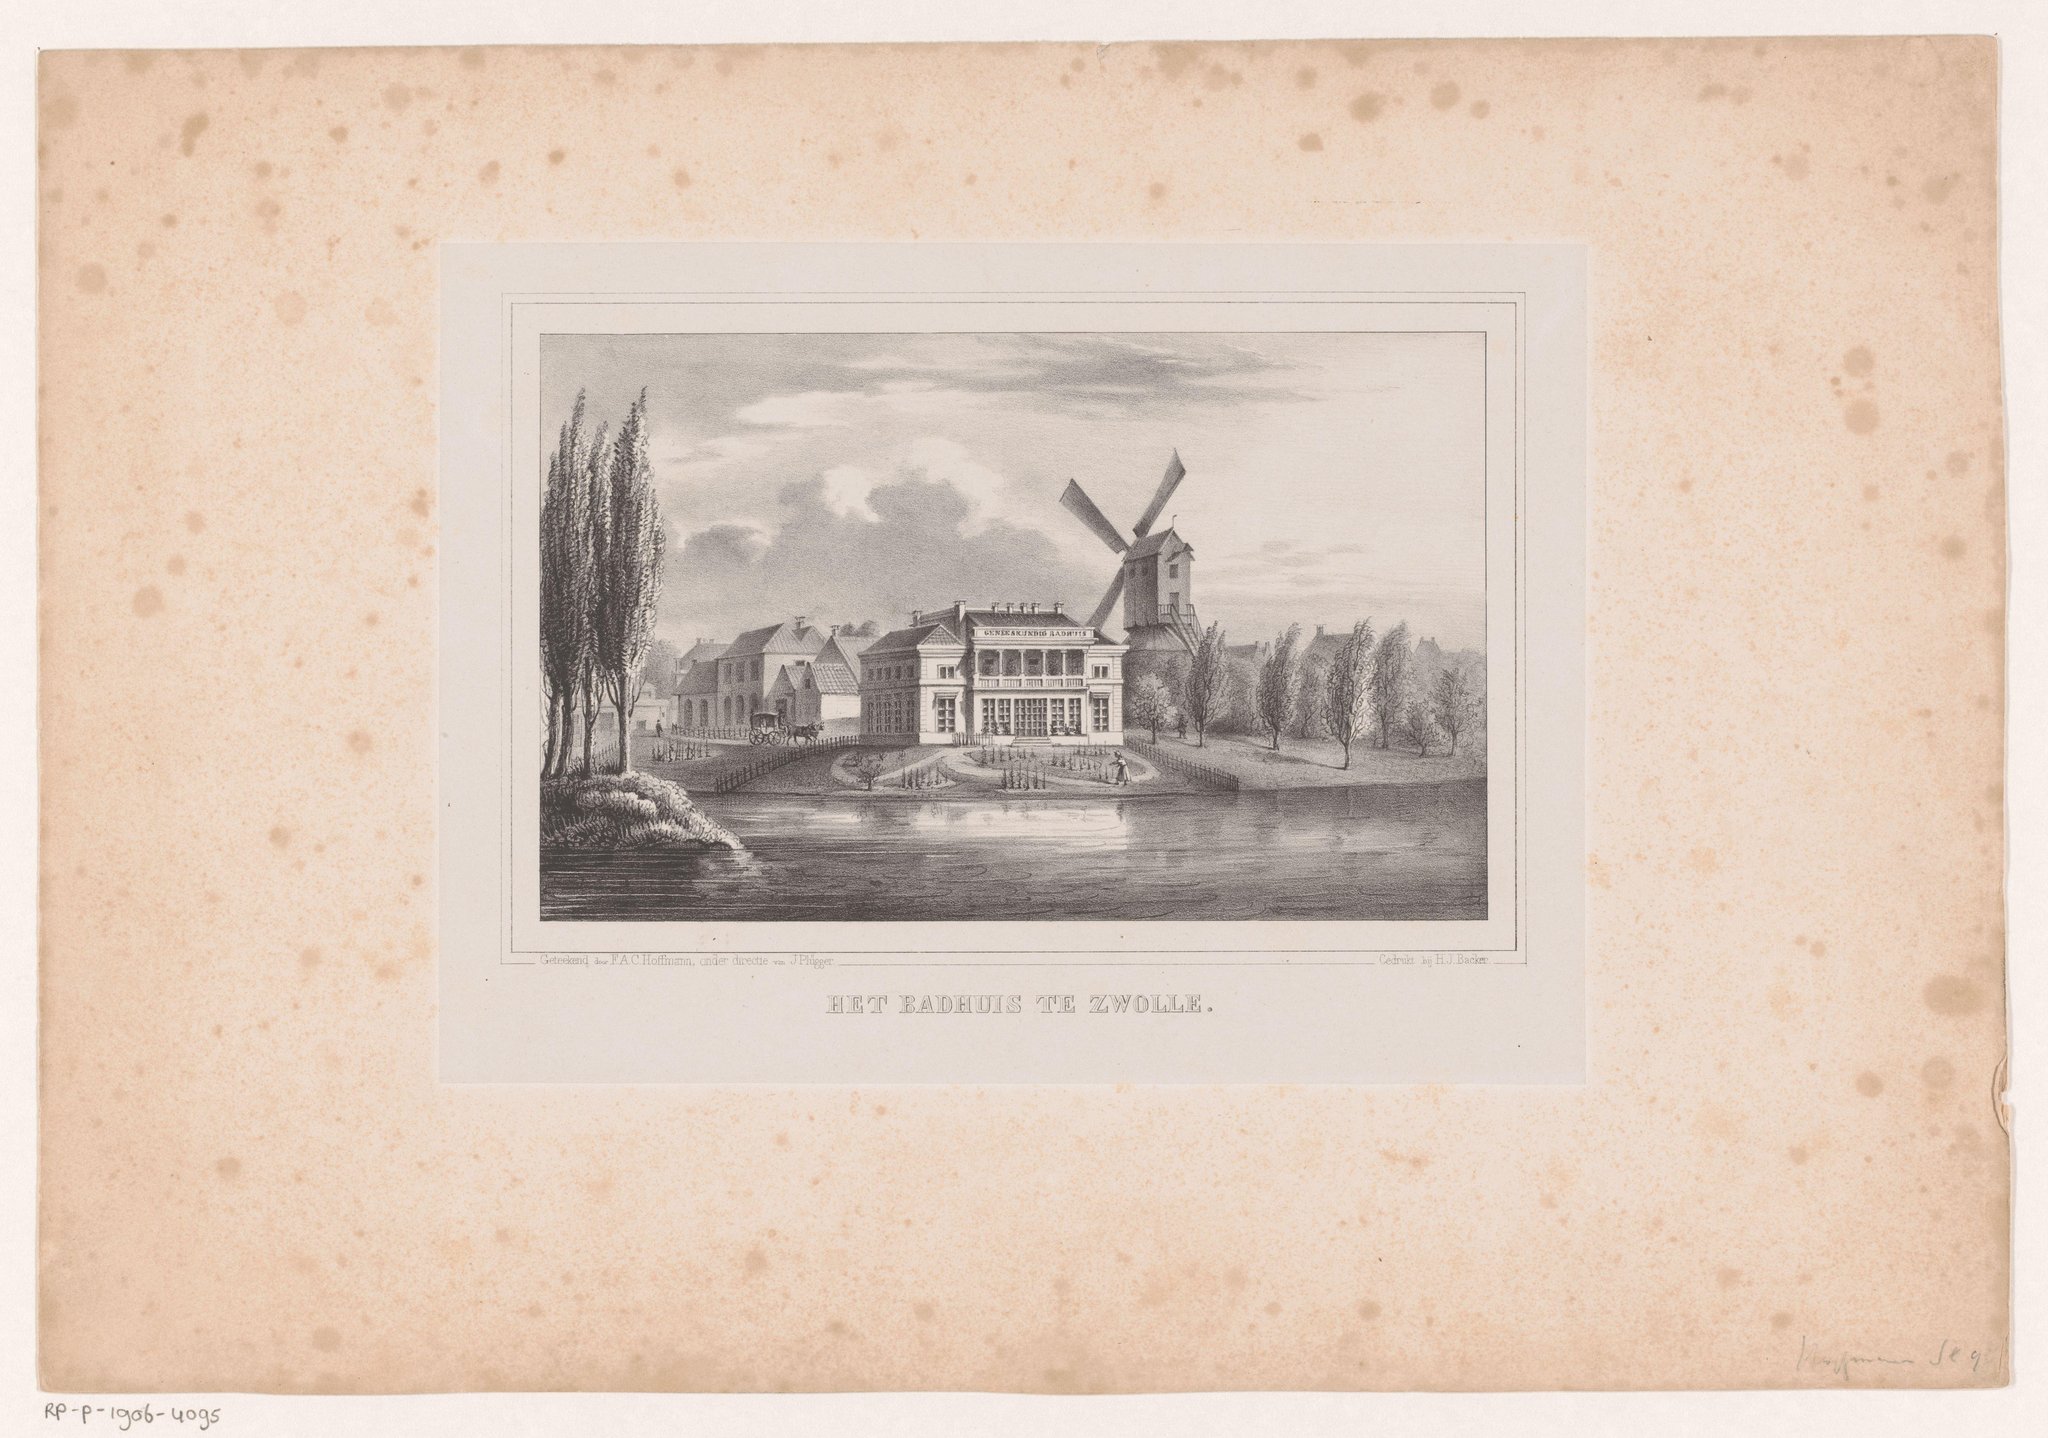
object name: print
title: Het badhuis te Zwolle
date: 1832-1845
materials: paper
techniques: lithograph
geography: zwolle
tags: public baths, windmill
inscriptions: collector's mark: Lugt 2228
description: Voor het huis, aan het water, ligt een tuin. Op de gevel staat: Geneeskundig Badhuis. Rechts een molen.